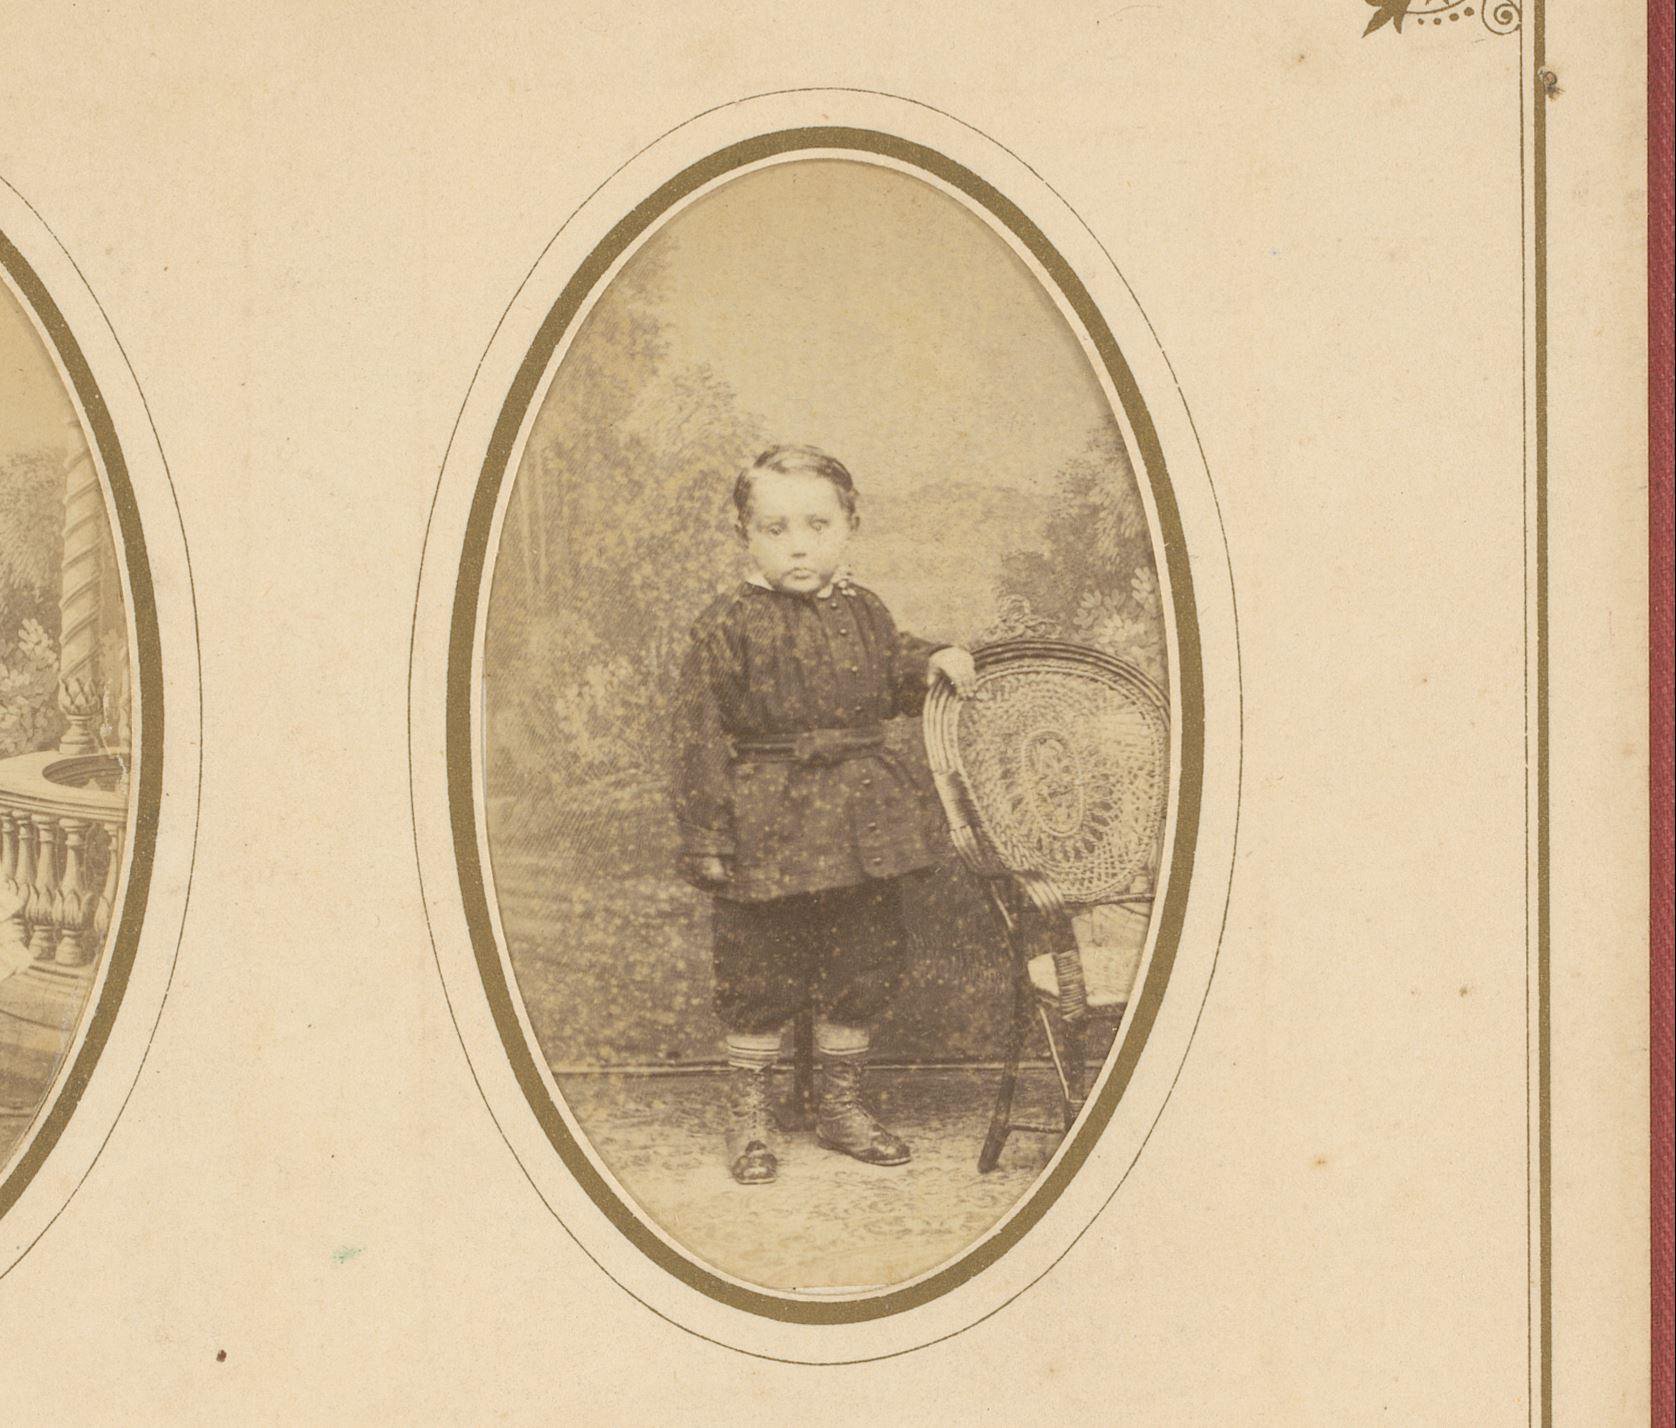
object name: photograph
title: Portret van een jongen, staand bij een stoel, aangeduid als Derk van der Wal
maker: benjamin van der heide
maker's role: fotograaf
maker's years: 1837-1928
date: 1866-1877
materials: cardboard, photographic support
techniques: albumen print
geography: harlingen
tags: historical persons, toddler (male), chair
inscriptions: inscription: ‘PHOTOGRAPHIE/ van/ B. VAN DER HEIDE/ bij de Westerkerk/ HARLINGEN.’, annotation: ‘Derk van der Wal/ 3 1/2 jaar.’